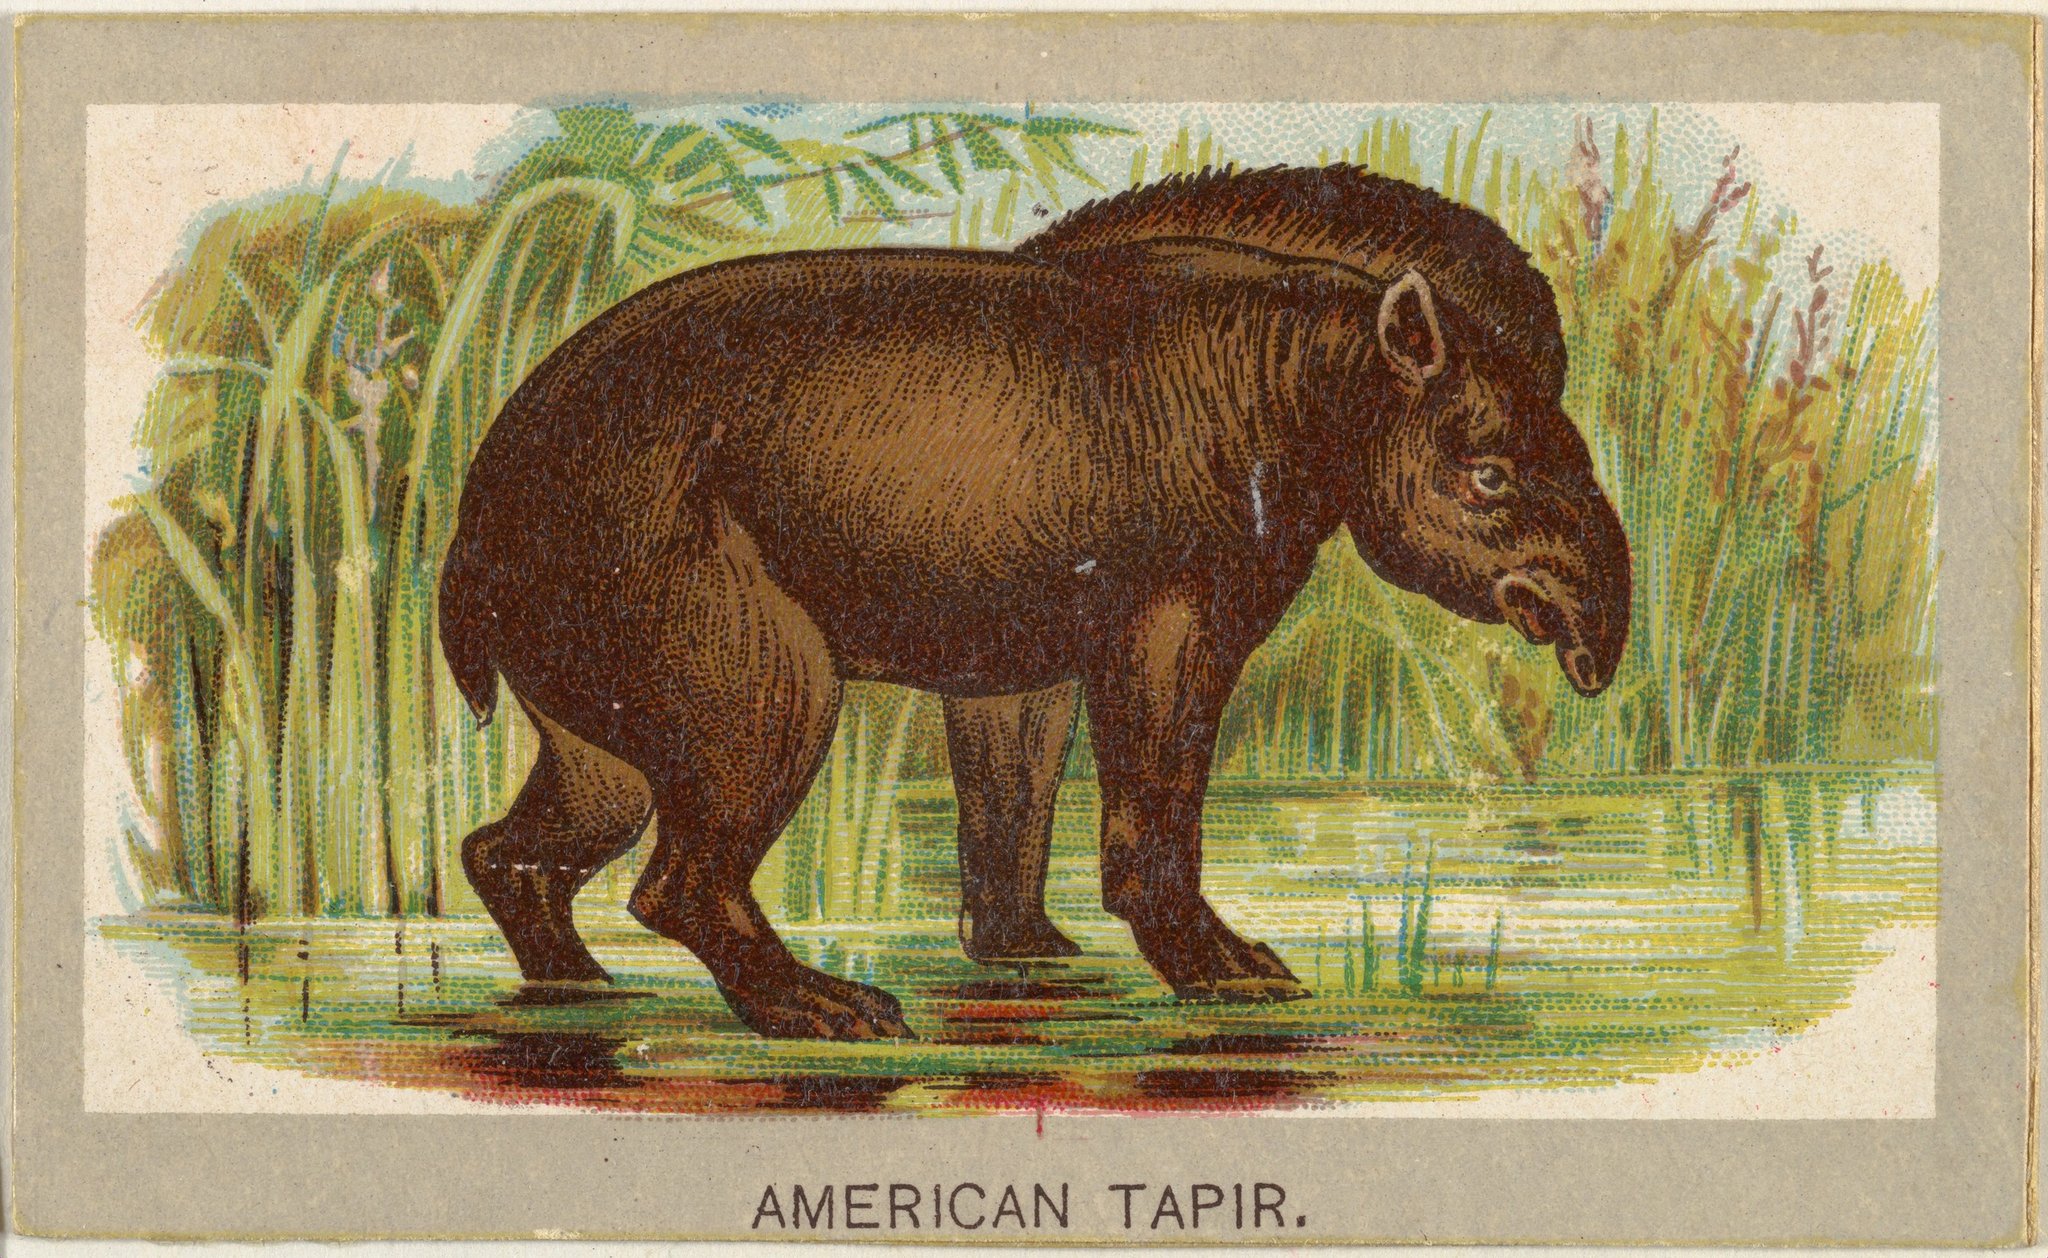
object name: print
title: American Tapir, from the Animals of the World series (T180), issued by Abdul Cigarettes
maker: abdul cigarettes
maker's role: publisher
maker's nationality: american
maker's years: 1881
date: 1881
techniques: color lithograph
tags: animals